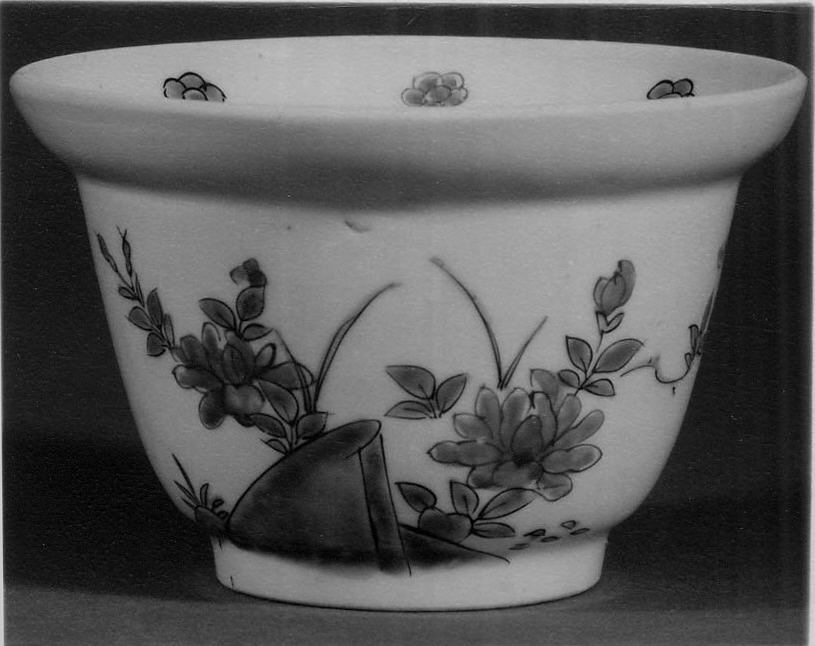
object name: cup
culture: japanese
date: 1601-1700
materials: enamel, porcelain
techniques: overglaze, painting, polychrome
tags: flowers,leaves